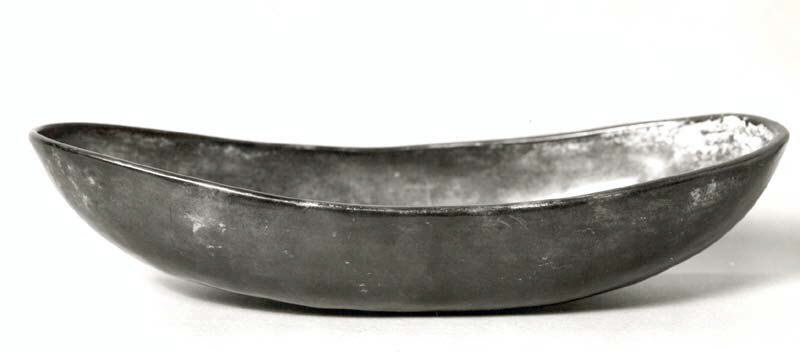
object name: bowl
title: Oval bowl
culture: sasanian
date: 501-700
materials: bronze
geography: iran